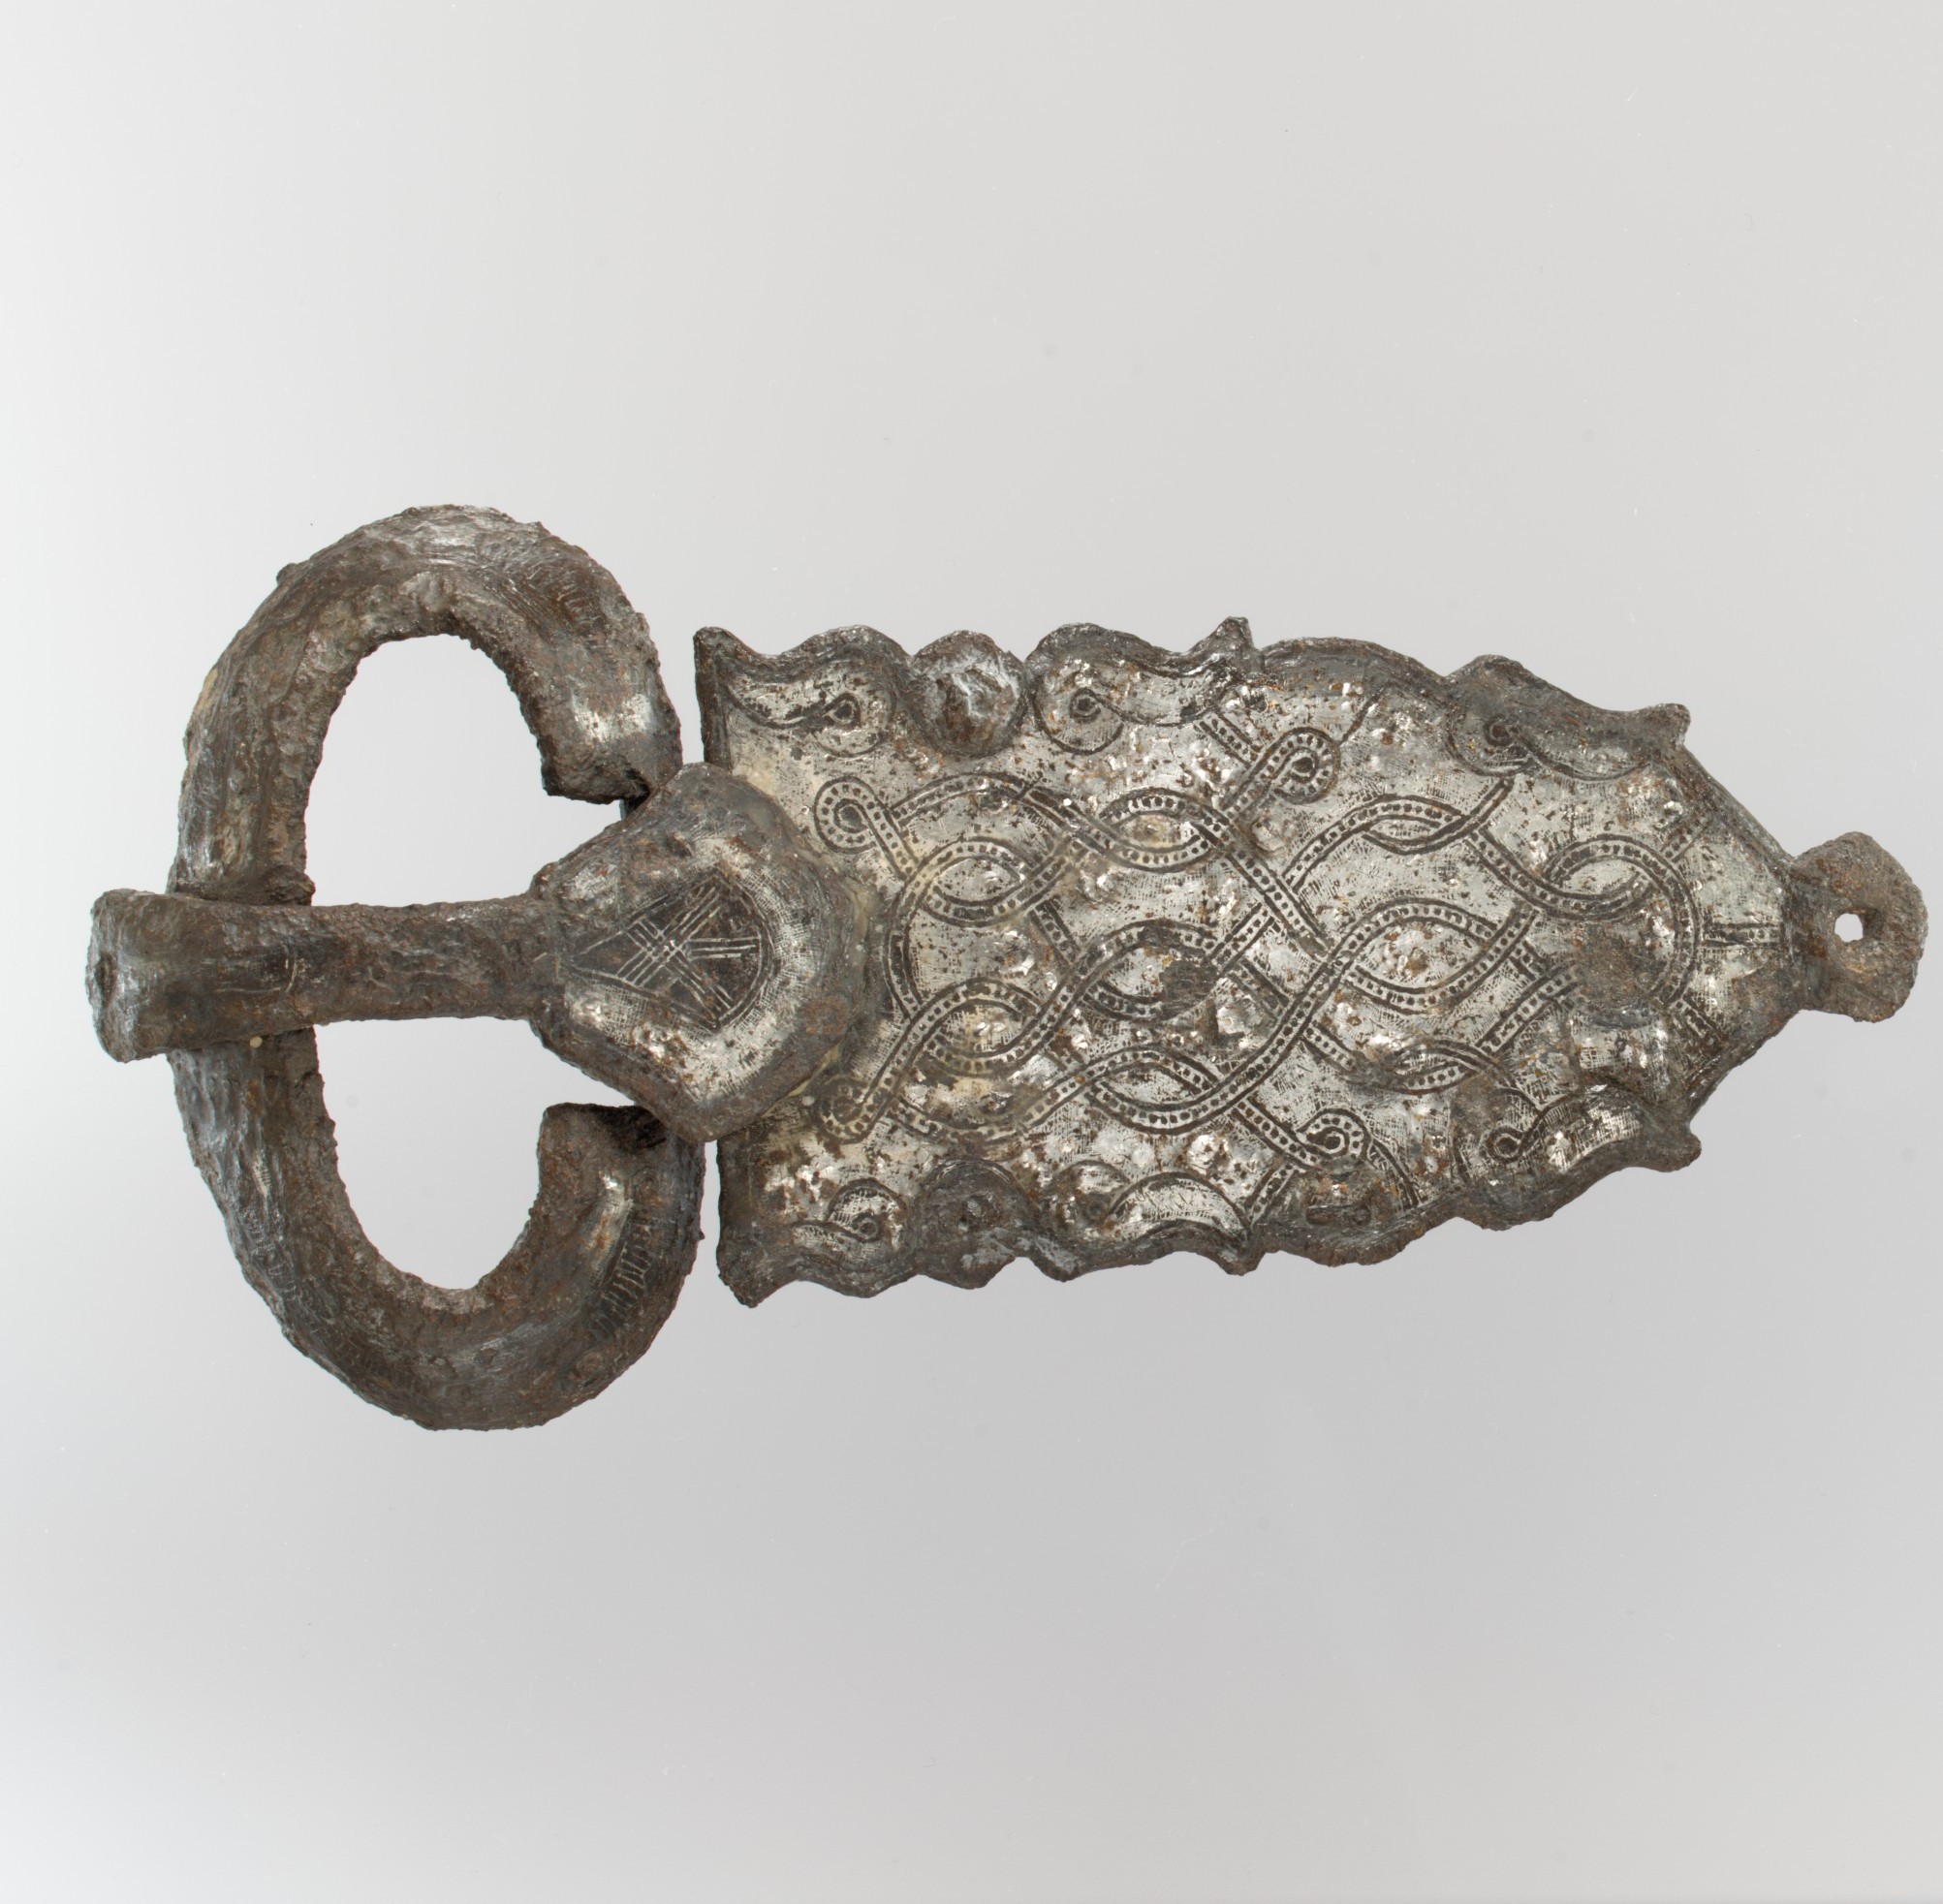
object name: belt buckle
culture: frankish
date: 600-700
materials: iron, silver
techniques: inlay